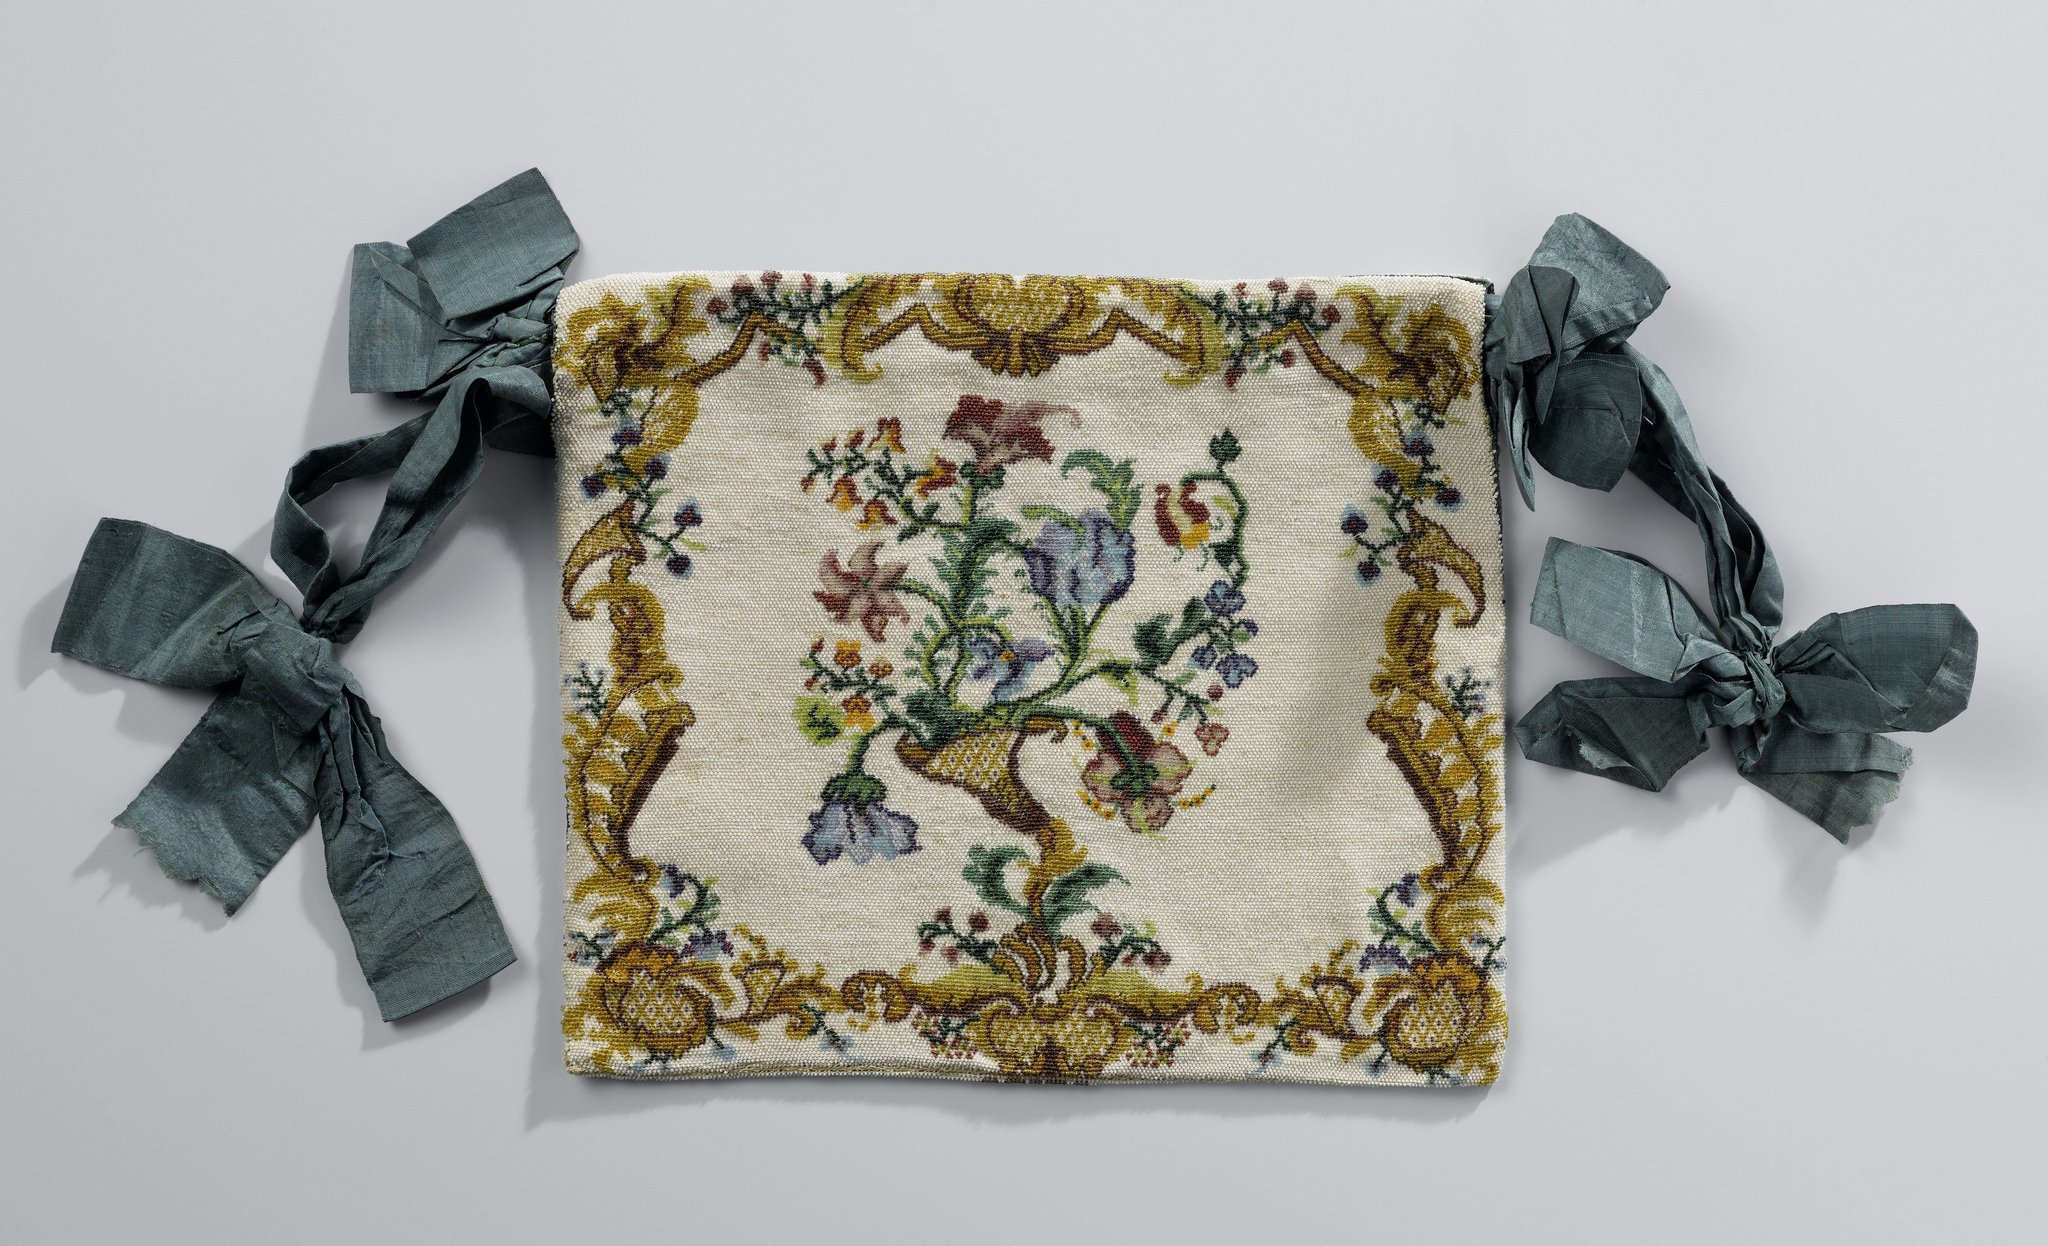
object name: bag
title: Frivolitétas in een plat, rechthoekig model, geheel gebreid met veelkleurige kralen, in het midden een boeket bloemen op crèmekleurig fond langs de randen omgeven door ornamentale rand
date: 1725-1750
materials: glass, silk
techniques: knitting, weave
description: Tasje, geborduurd (?) met fijne kleurige kraaltjes, met groenblauw ripslint. Rokoko. Plat, breed zakmodel; met groenblauwe zijden voering. Bovenaan met sleuven waarin linten, die gestrikt beginnen en eindigen. Beide helften van de tas zijn gelijk. Midden: Een asymmetrisch kelkvormige bloemenmand, naar links overbuigend en staande op een s-vormige stee. Hieruit komen naar alle kanten slingerende stengels met blauwpaarse klokjesbloem, een paarsrode sterbloem, een pioen en een witte kelkbloem, afgewisseld door bloemtrosjes. Op een wit fond staat een symmetrische rokokorand in geel en bruin. Bovenaan ornamentlijnen uit een schelp en een rastermedaillon komend, terzijde ook ornamentlijnen, nu omspeeld met een hoorn van overvloed, s-voluut wn klein blauw bloemtakje. In de benedenhoek een c-voluut-rastermedaillon. Onderaan c-voluten en s-bladeren op een rasterschelp vorm.